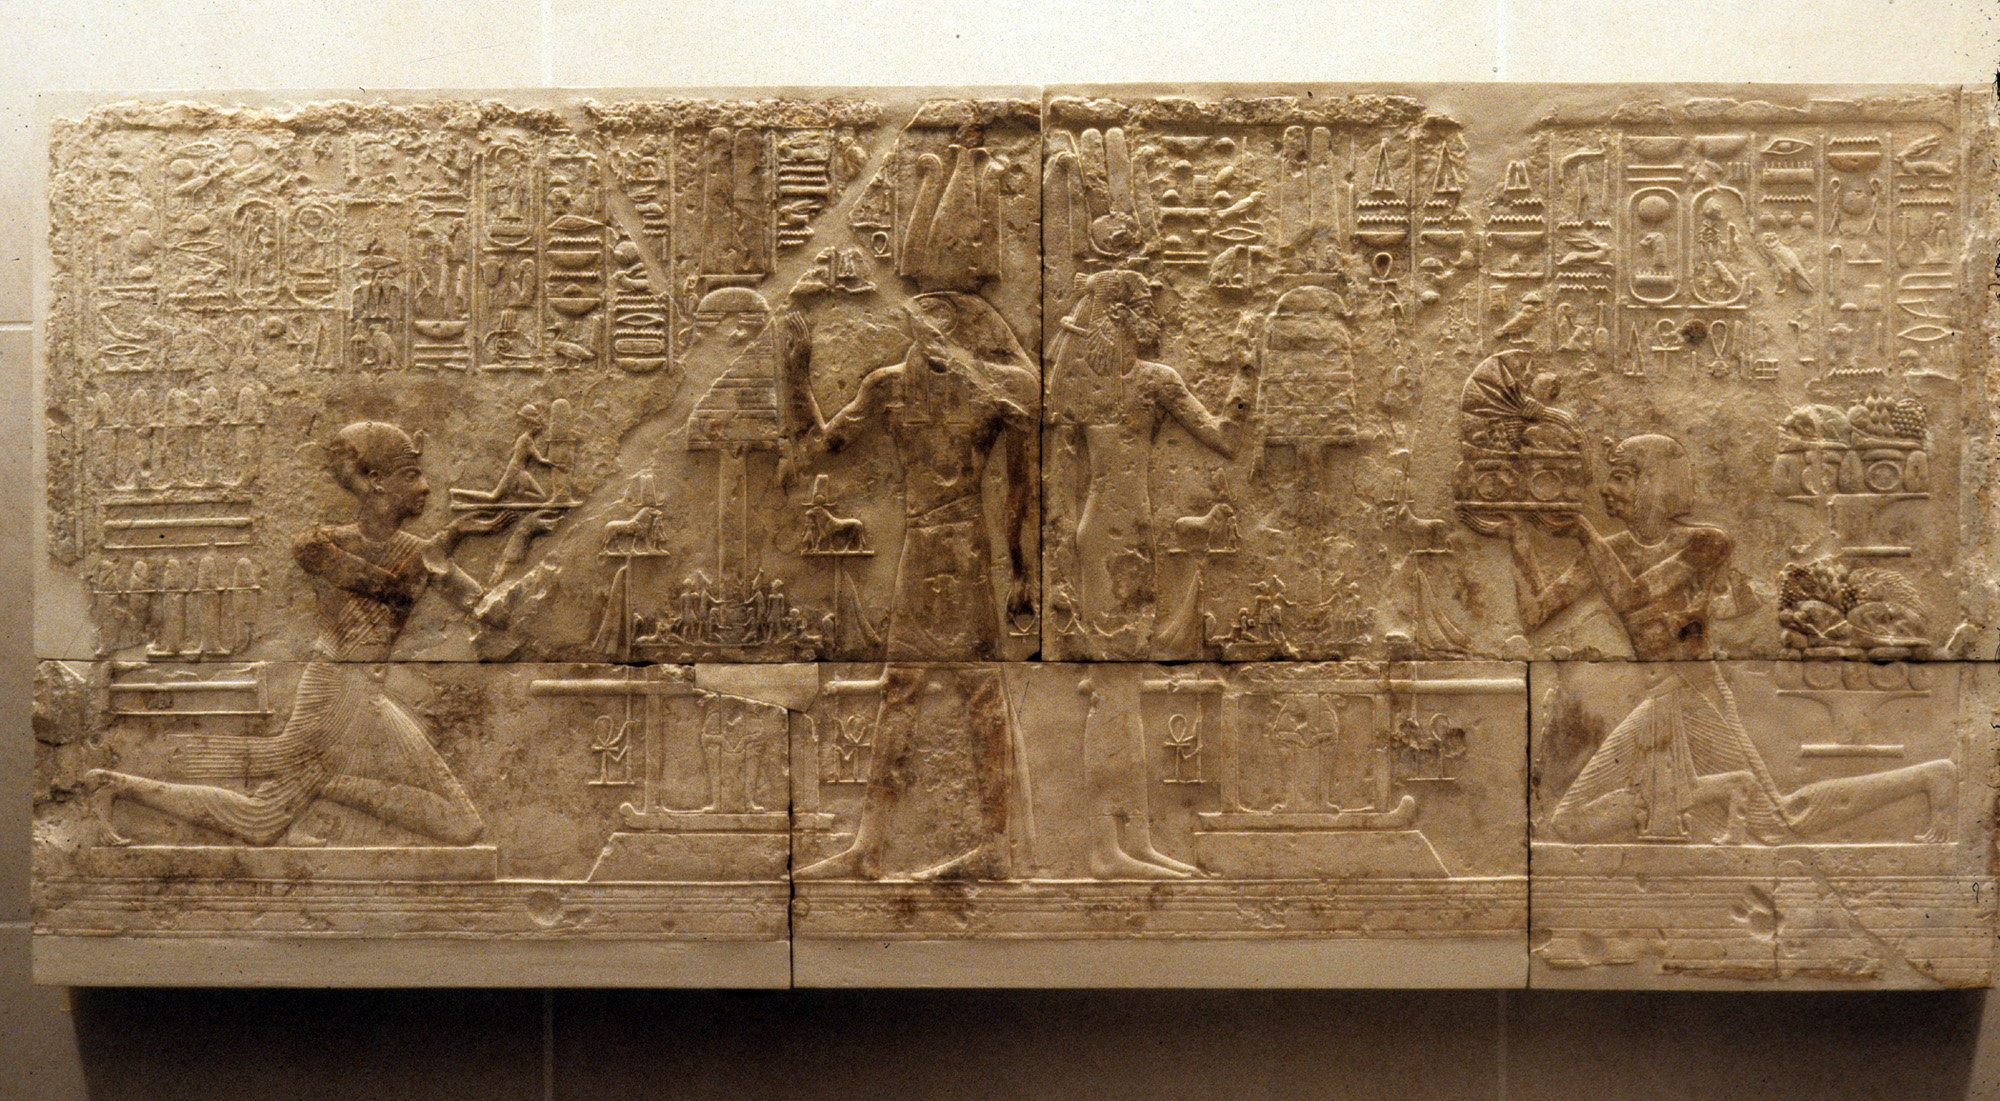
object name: relief, ramesses i chapel, south wall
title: Relief from the West Wall of a Chapel of Ramesses I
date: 1295-1294 BCE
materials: limestone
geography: egypt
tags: men,hieroglyphs